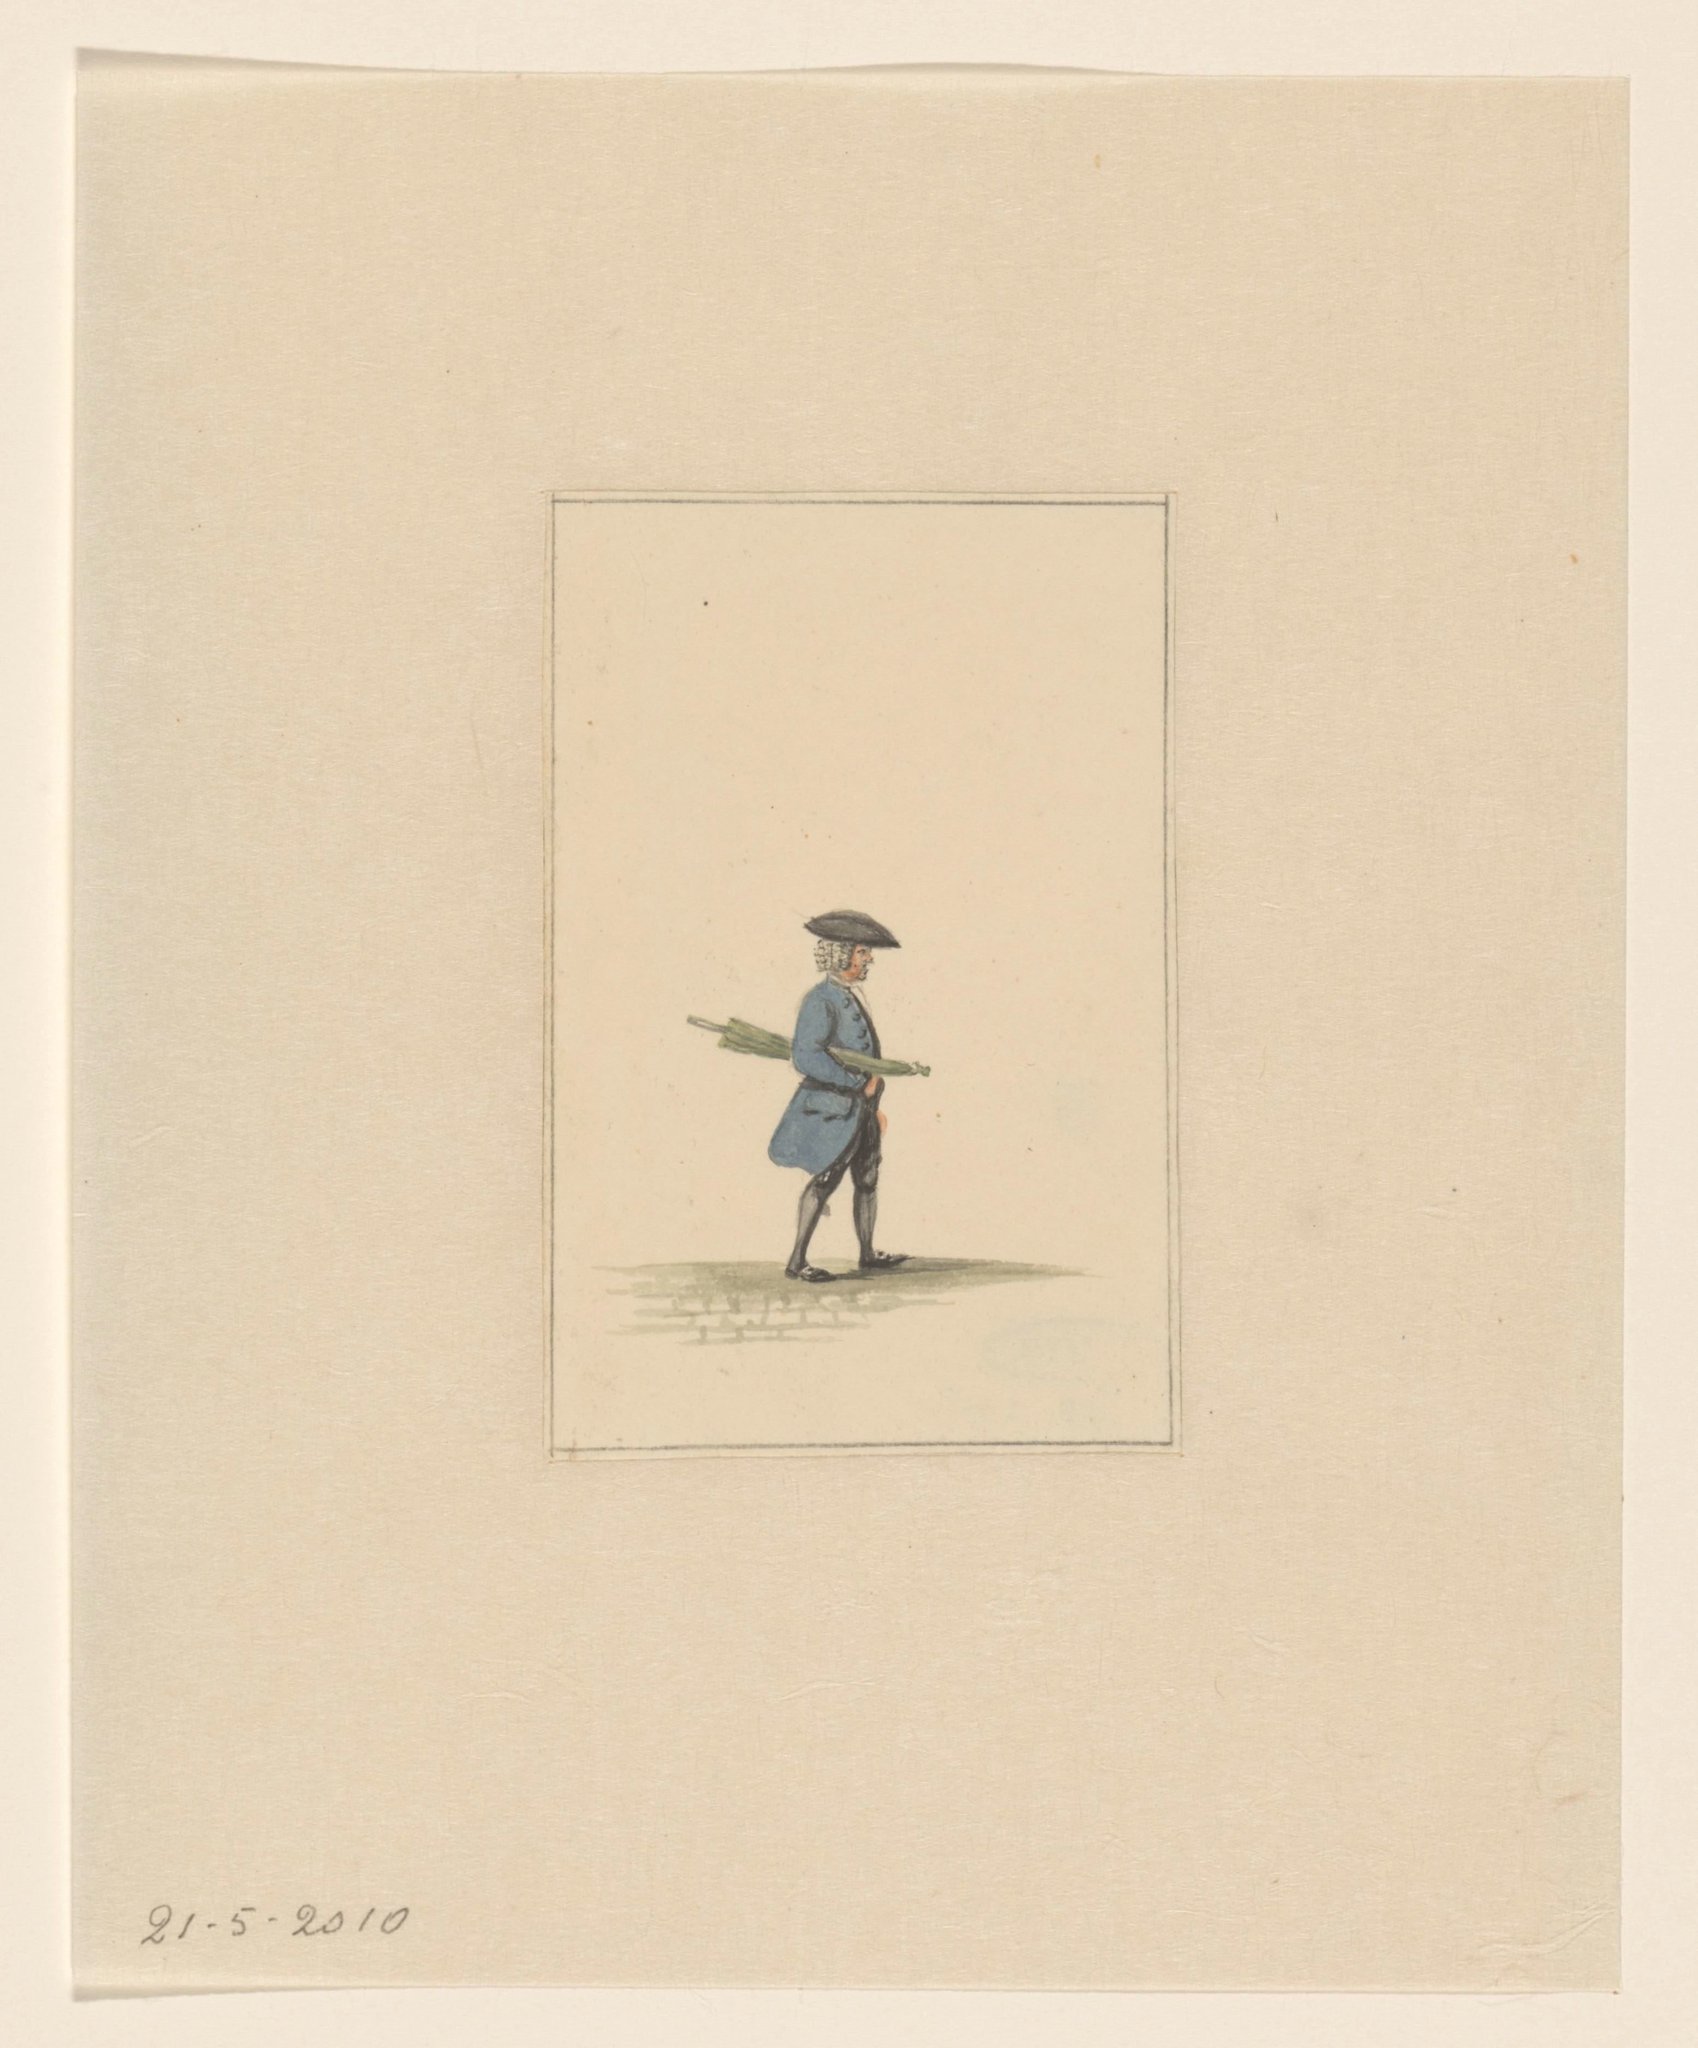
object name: drawing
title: Wandelende heer met paraplu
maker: joannes pieter visser bender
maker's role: draughtsman, print maker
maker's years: 1785-1813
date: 1795-1813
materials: paper, pencil, watercolor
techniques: brush